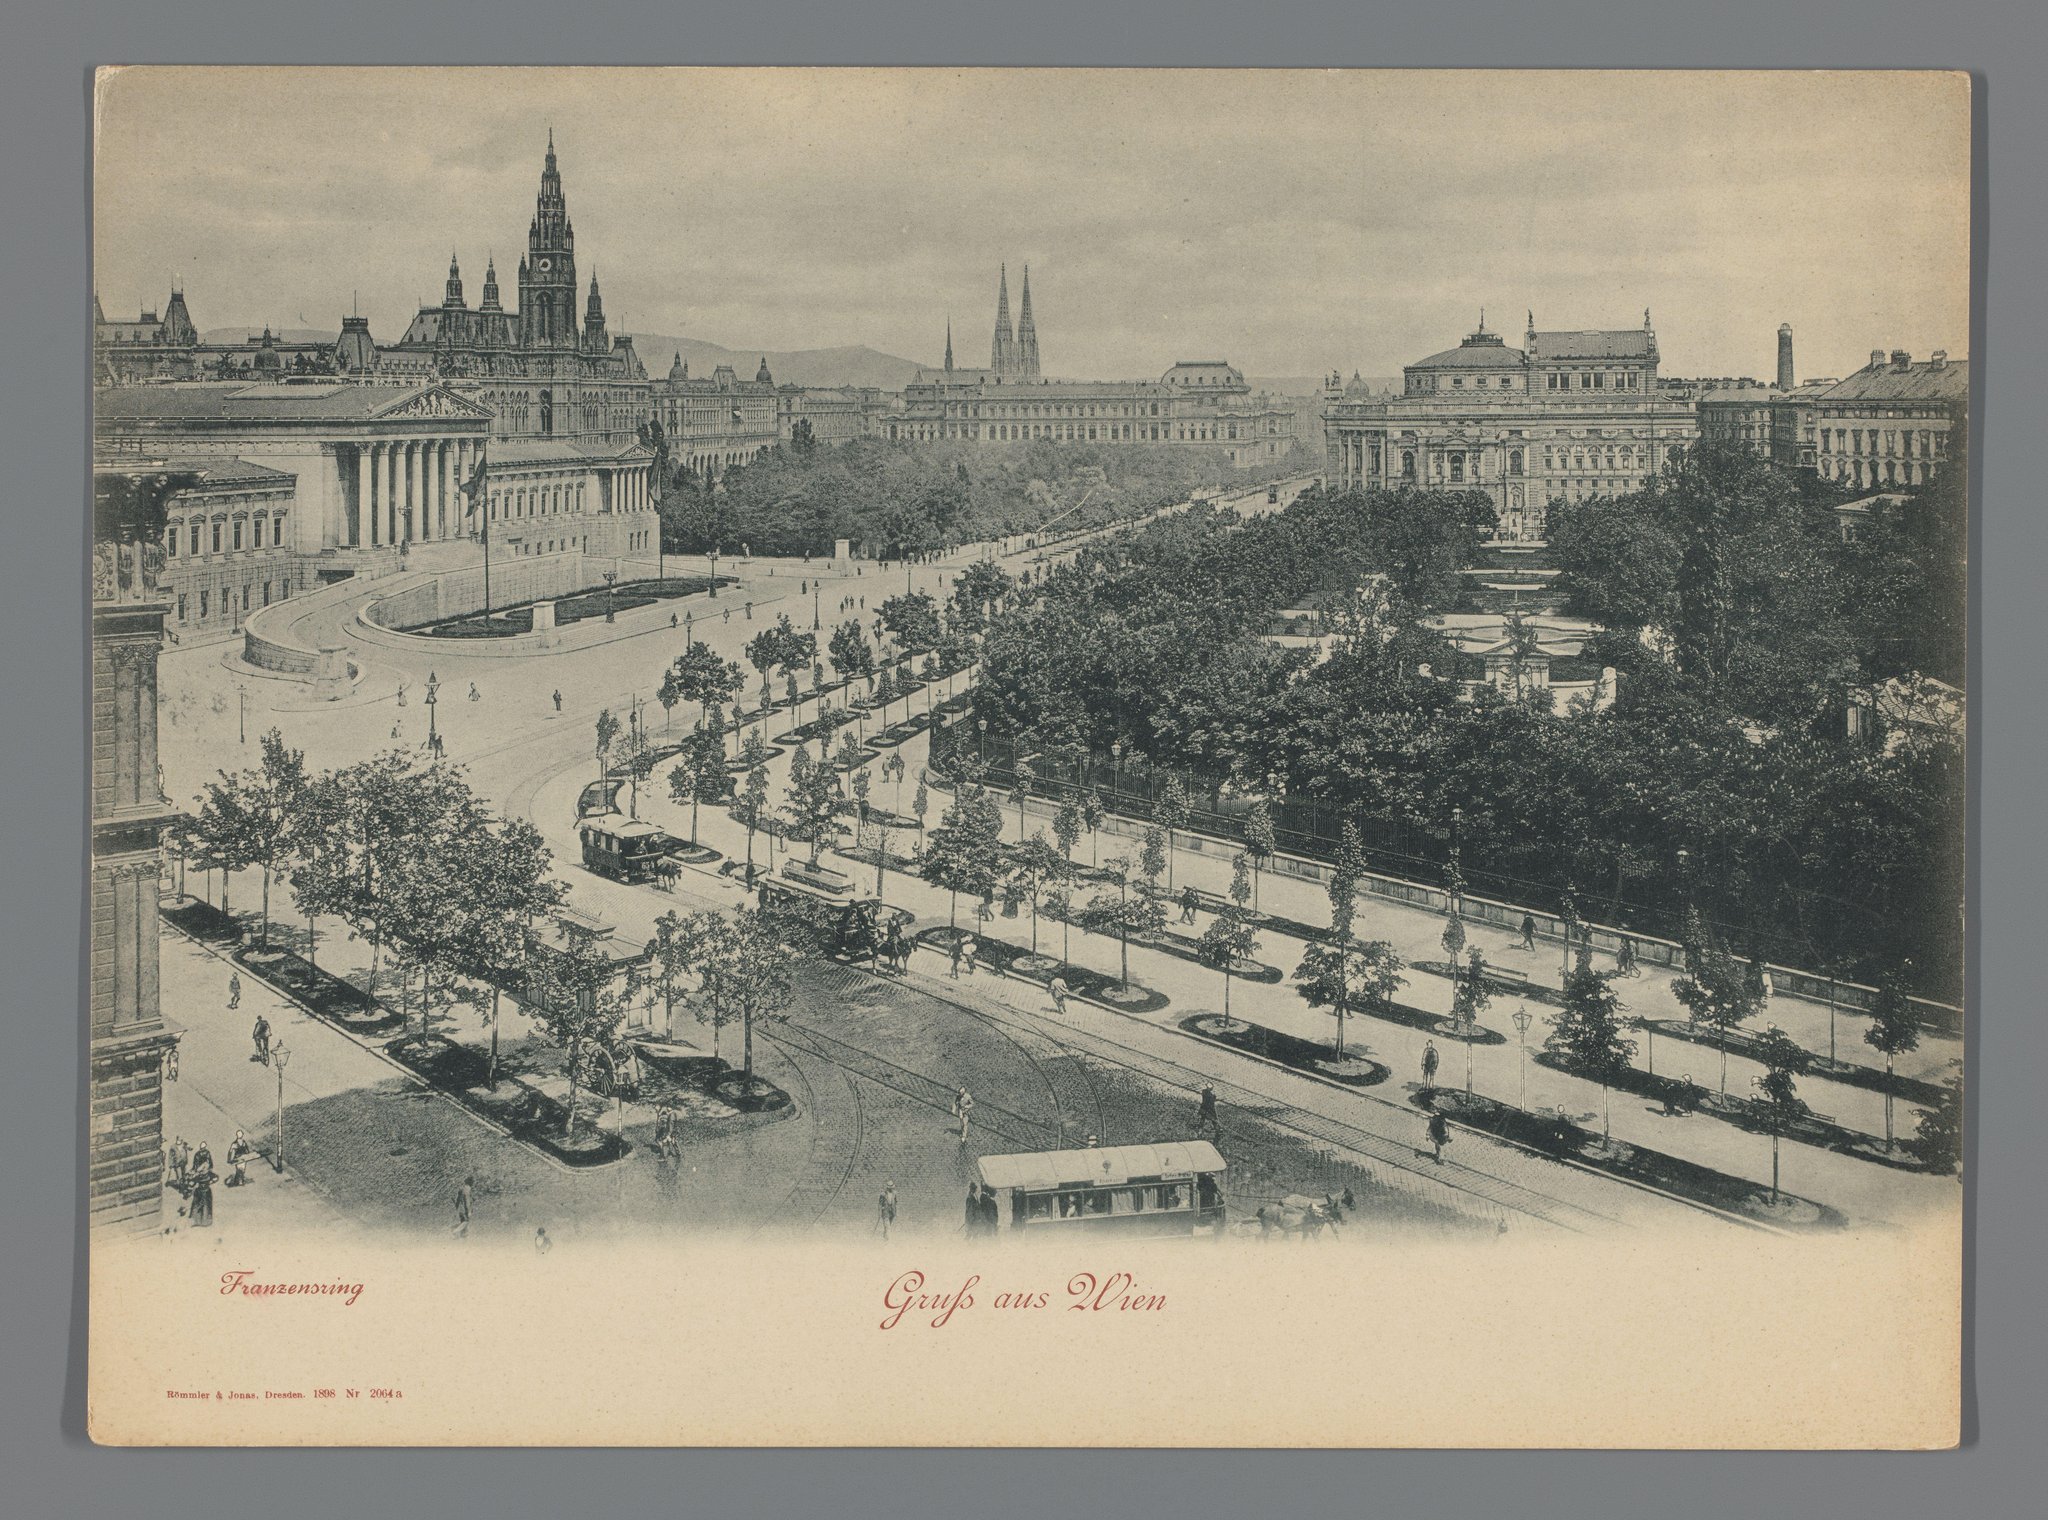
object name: photograph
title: Franzensring, Wien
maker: Anonymous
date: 1880-1920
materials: paper, photographic support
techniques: photograph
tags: vienna